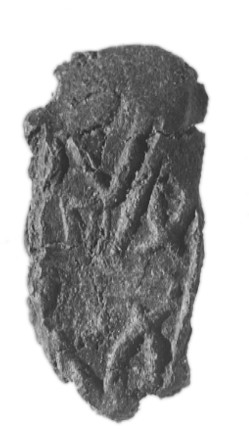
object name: sealing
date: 2030-1640 BCE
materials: clay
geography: egypt